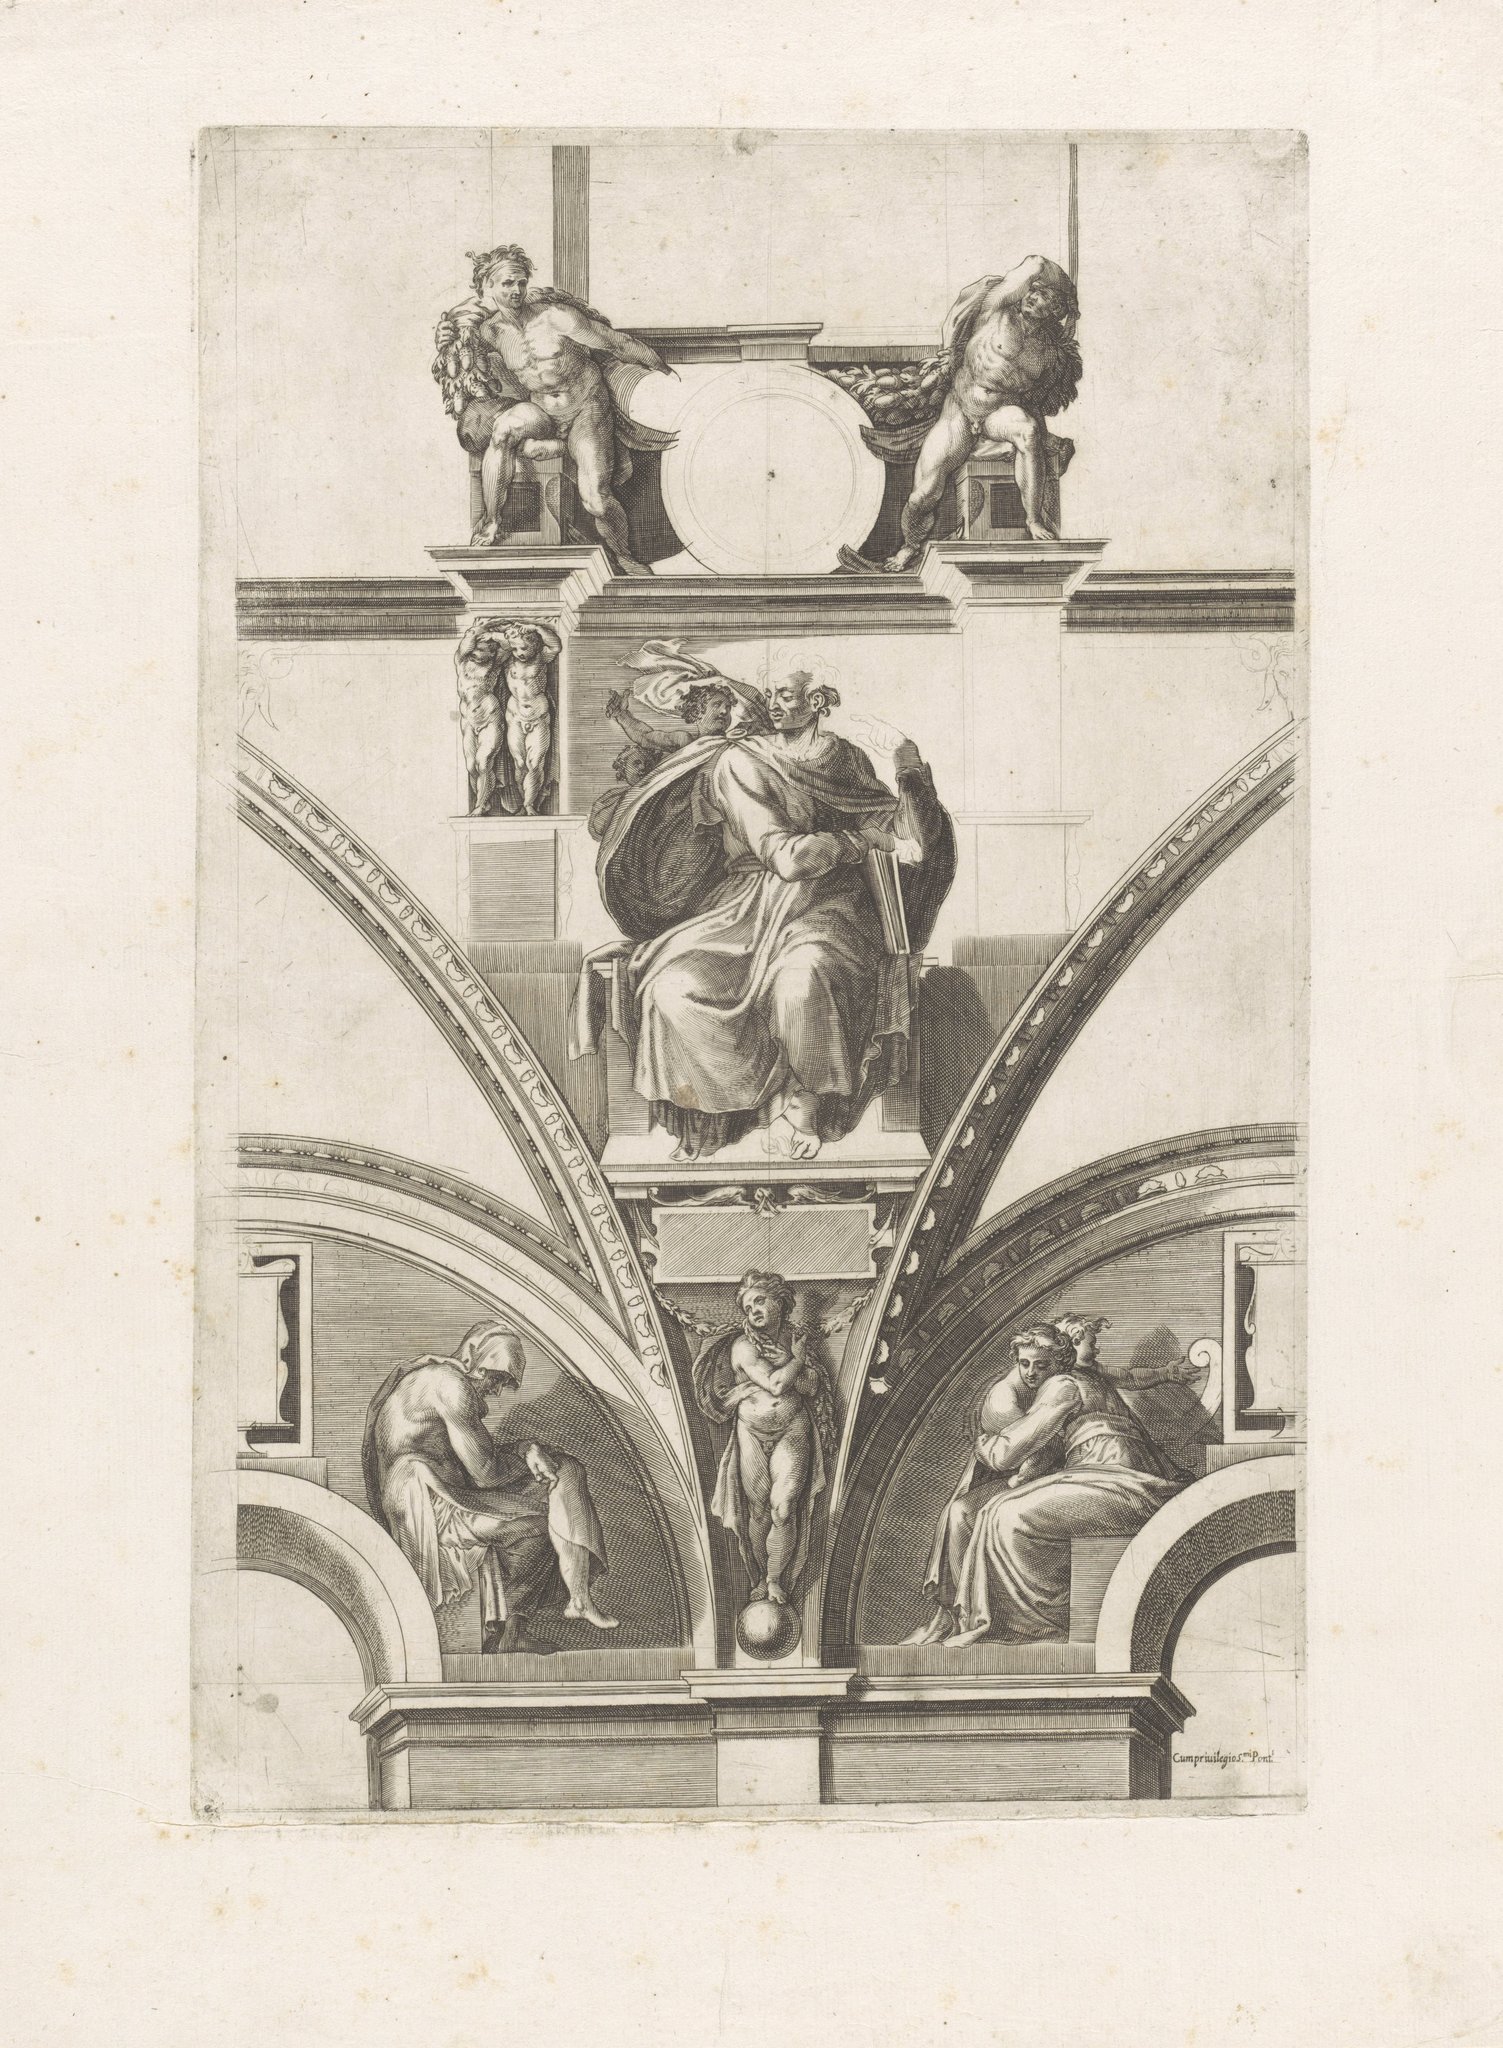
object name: print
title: Profeet Jesaja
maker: cherubino alberti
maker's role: draughtsman, print maker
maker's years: 1553-1615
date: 1628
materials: paper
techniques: engraving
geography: rome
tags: the (nude) human figure; 'corpo humano' (ripa), sibyls, prophets, sibyls, evangelists, doctors of the church; persons ~ the bible (not in biblical context)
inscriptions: collector's mark: Lugt 240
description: Deel van de gewelfschildering door Michelangelo in de Sixtijnse Kapel met sibillen, profeten en naakte figuren (ignudi). Centraal zit de Profeet Jesaja.